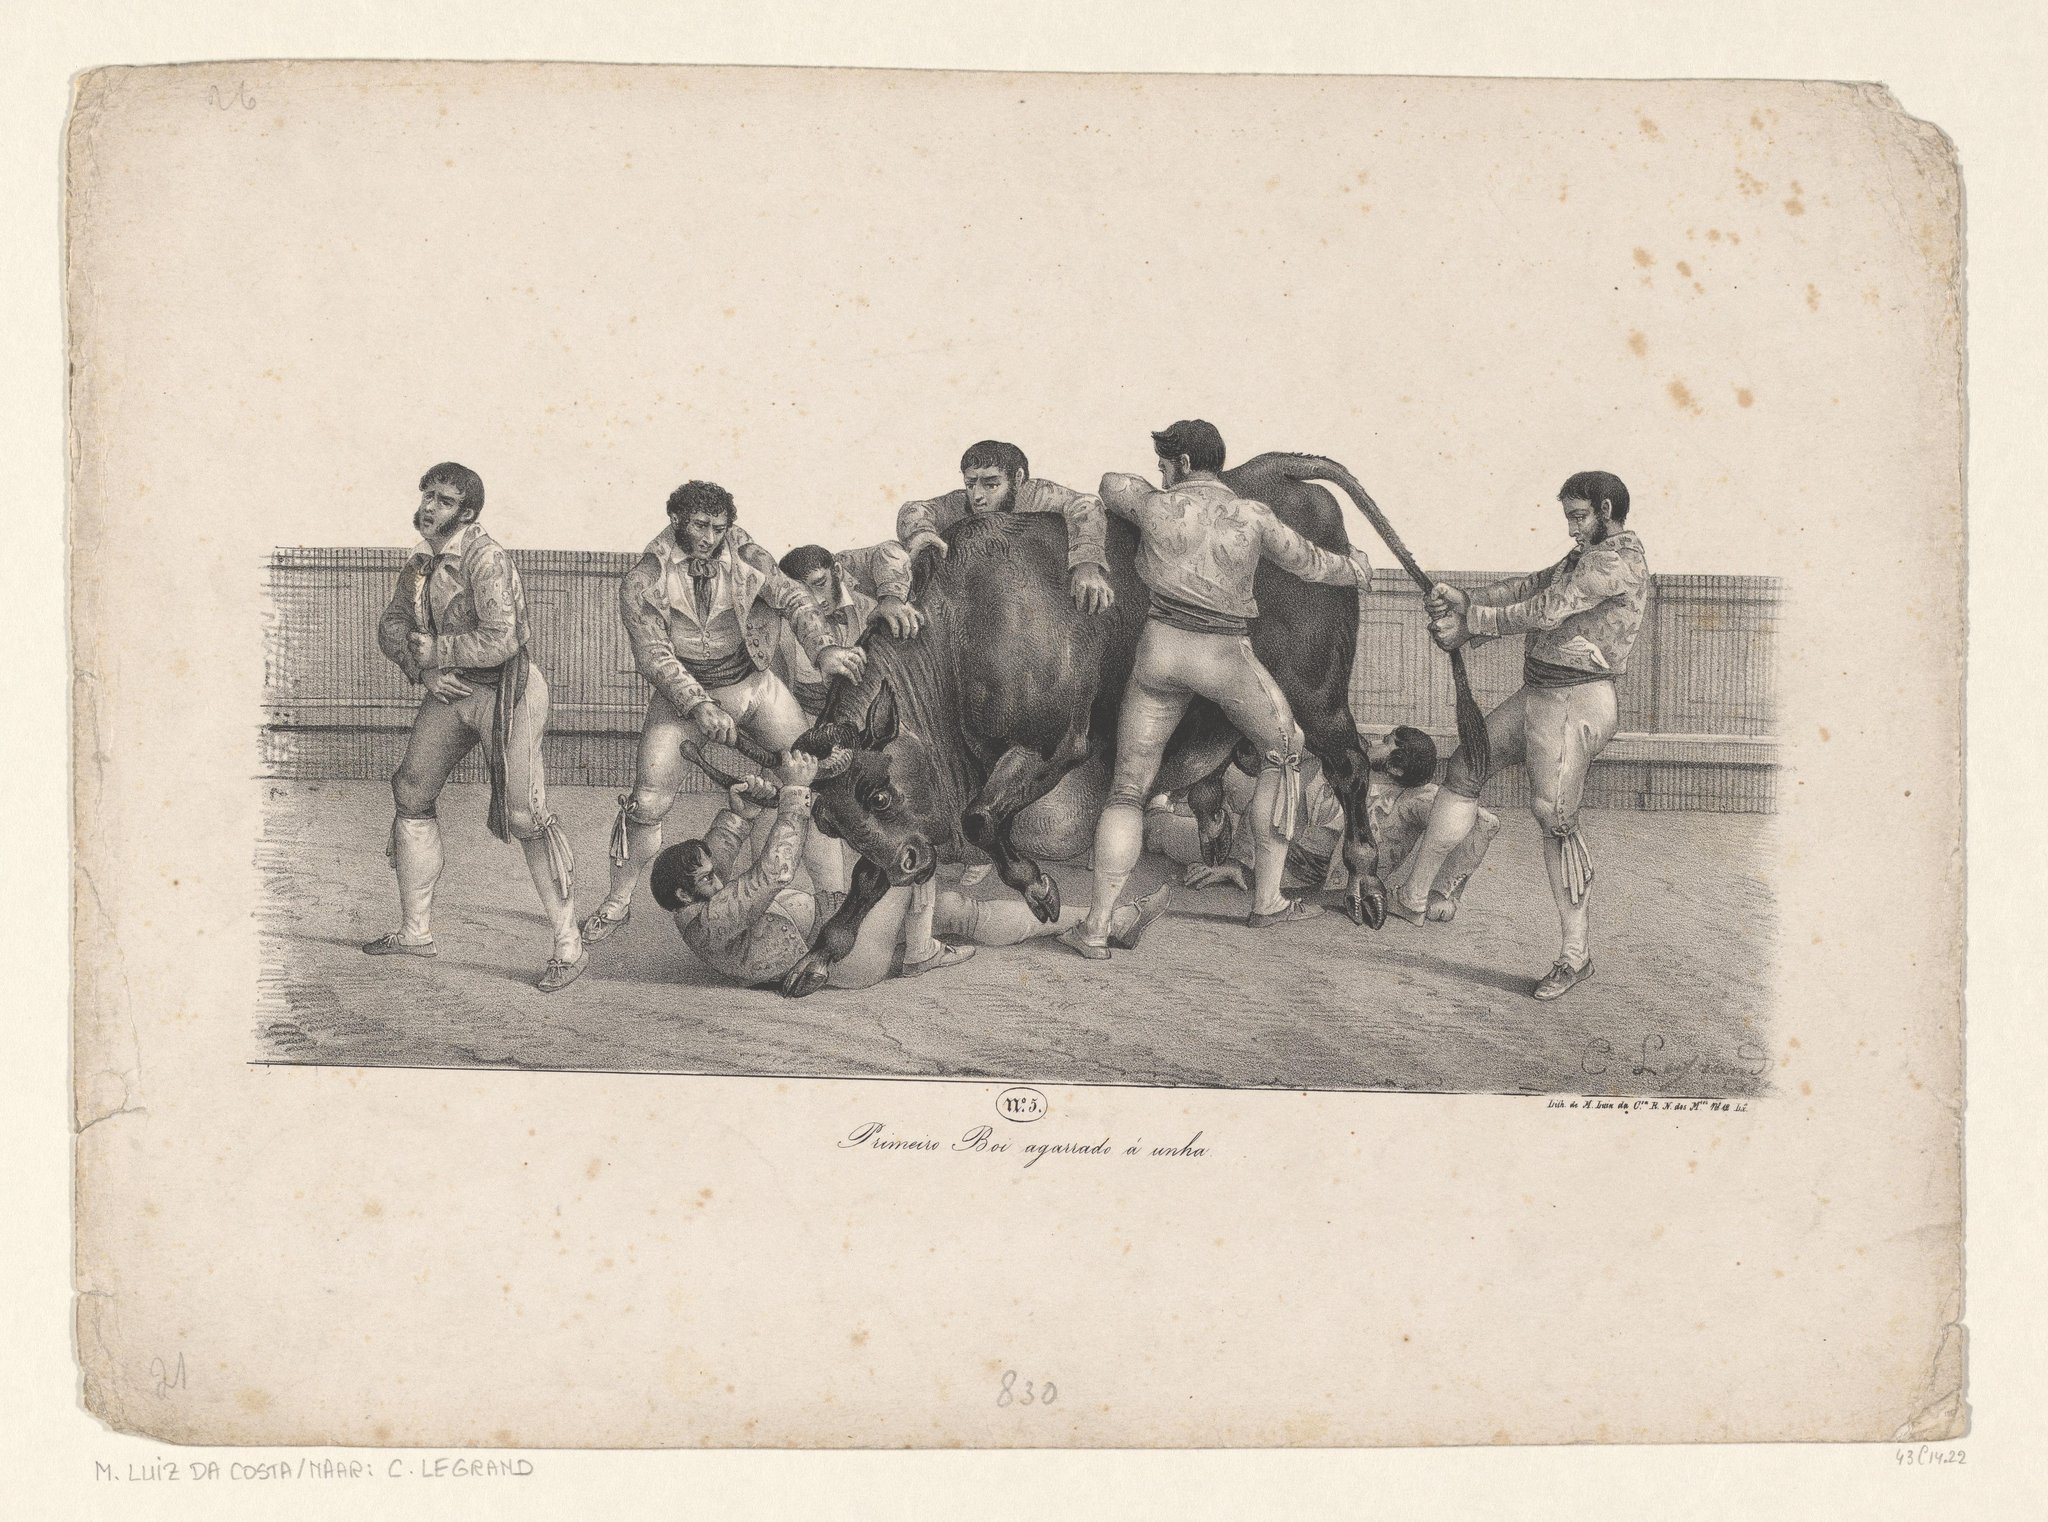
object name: print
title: Stierengevecht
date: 1830-1840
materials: paper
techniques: lithograph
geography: europe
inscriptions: collector's mark: Lugt 2228